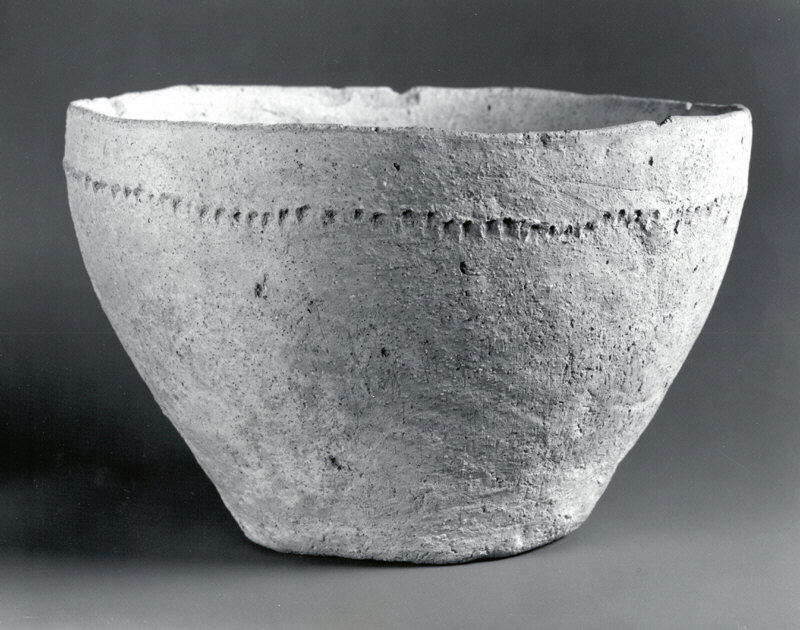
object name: bowl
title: Bowl with punctate decoration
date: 3500-3300 BCE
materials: ceramic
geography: levant